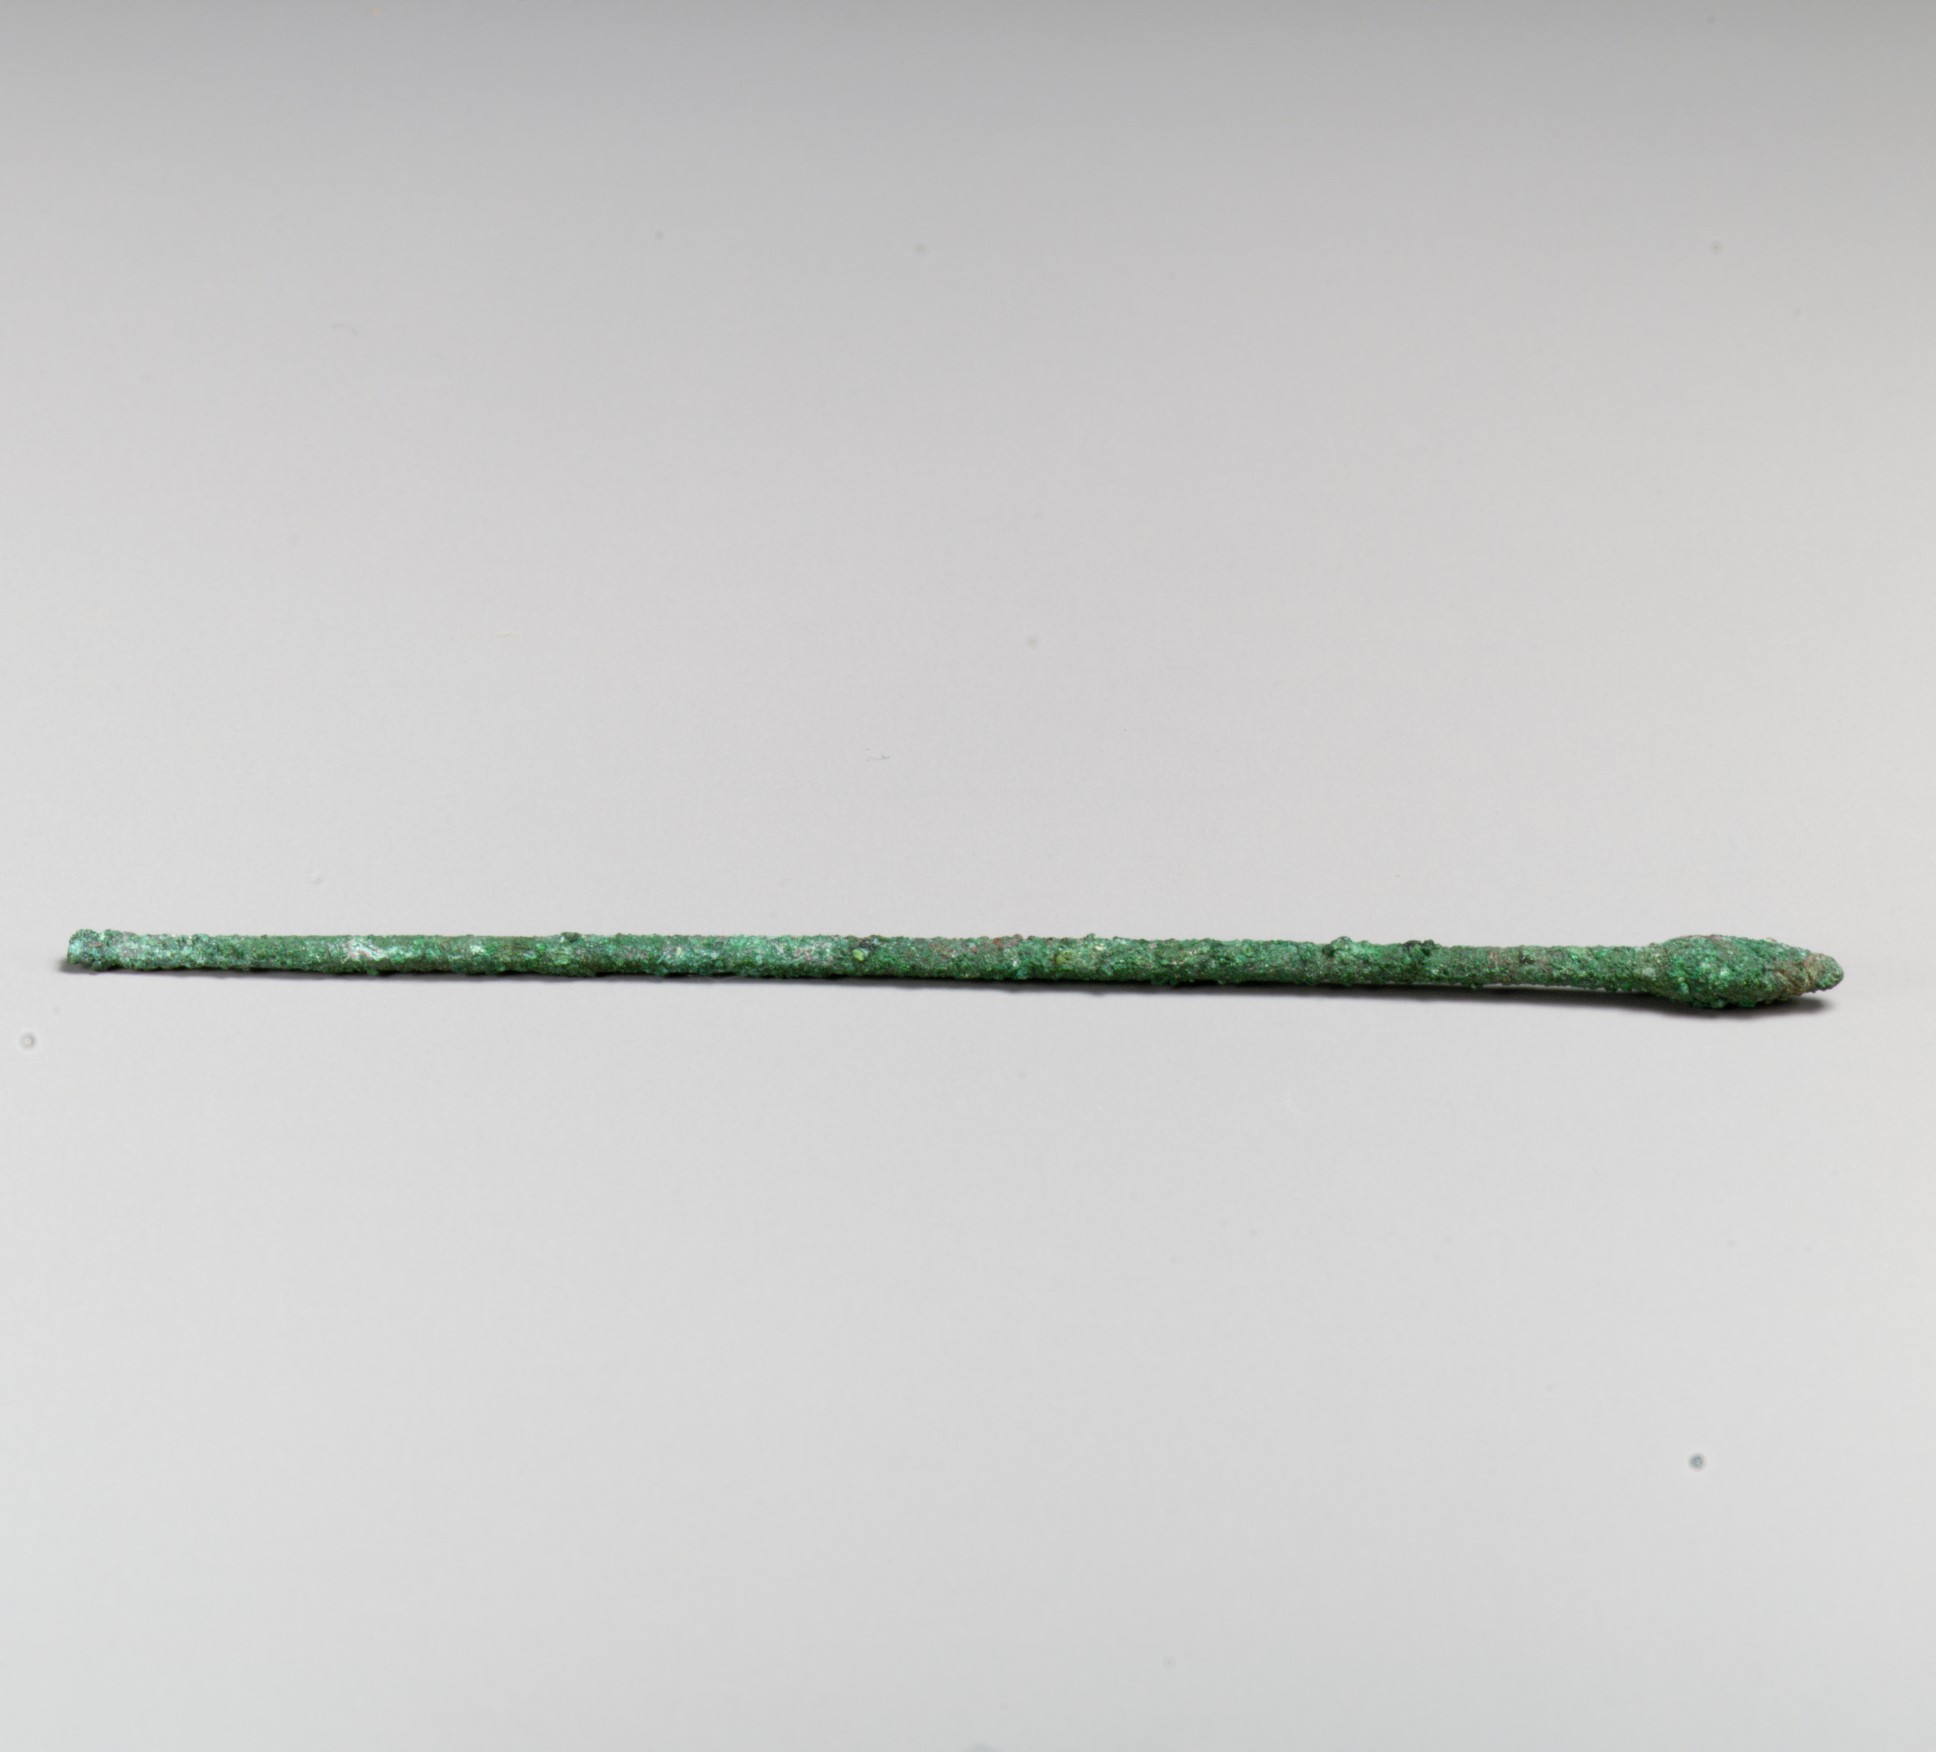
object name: rod, dipping, or pin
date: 7000 BCE-330 CE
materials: bronze